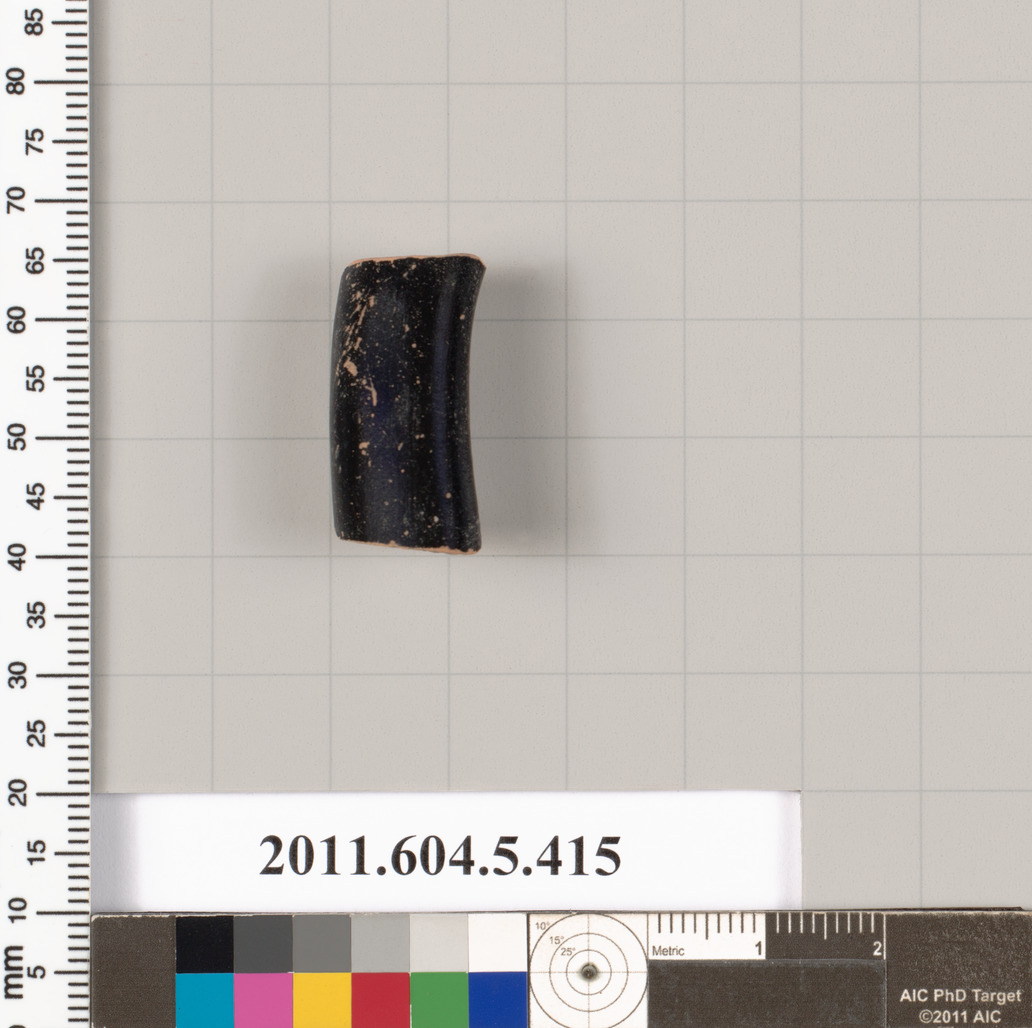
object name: kylix fragment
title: Terracotta fragment of a kylix (drinking cup)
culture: greek, attic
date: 600-401 BCE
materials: terracotta